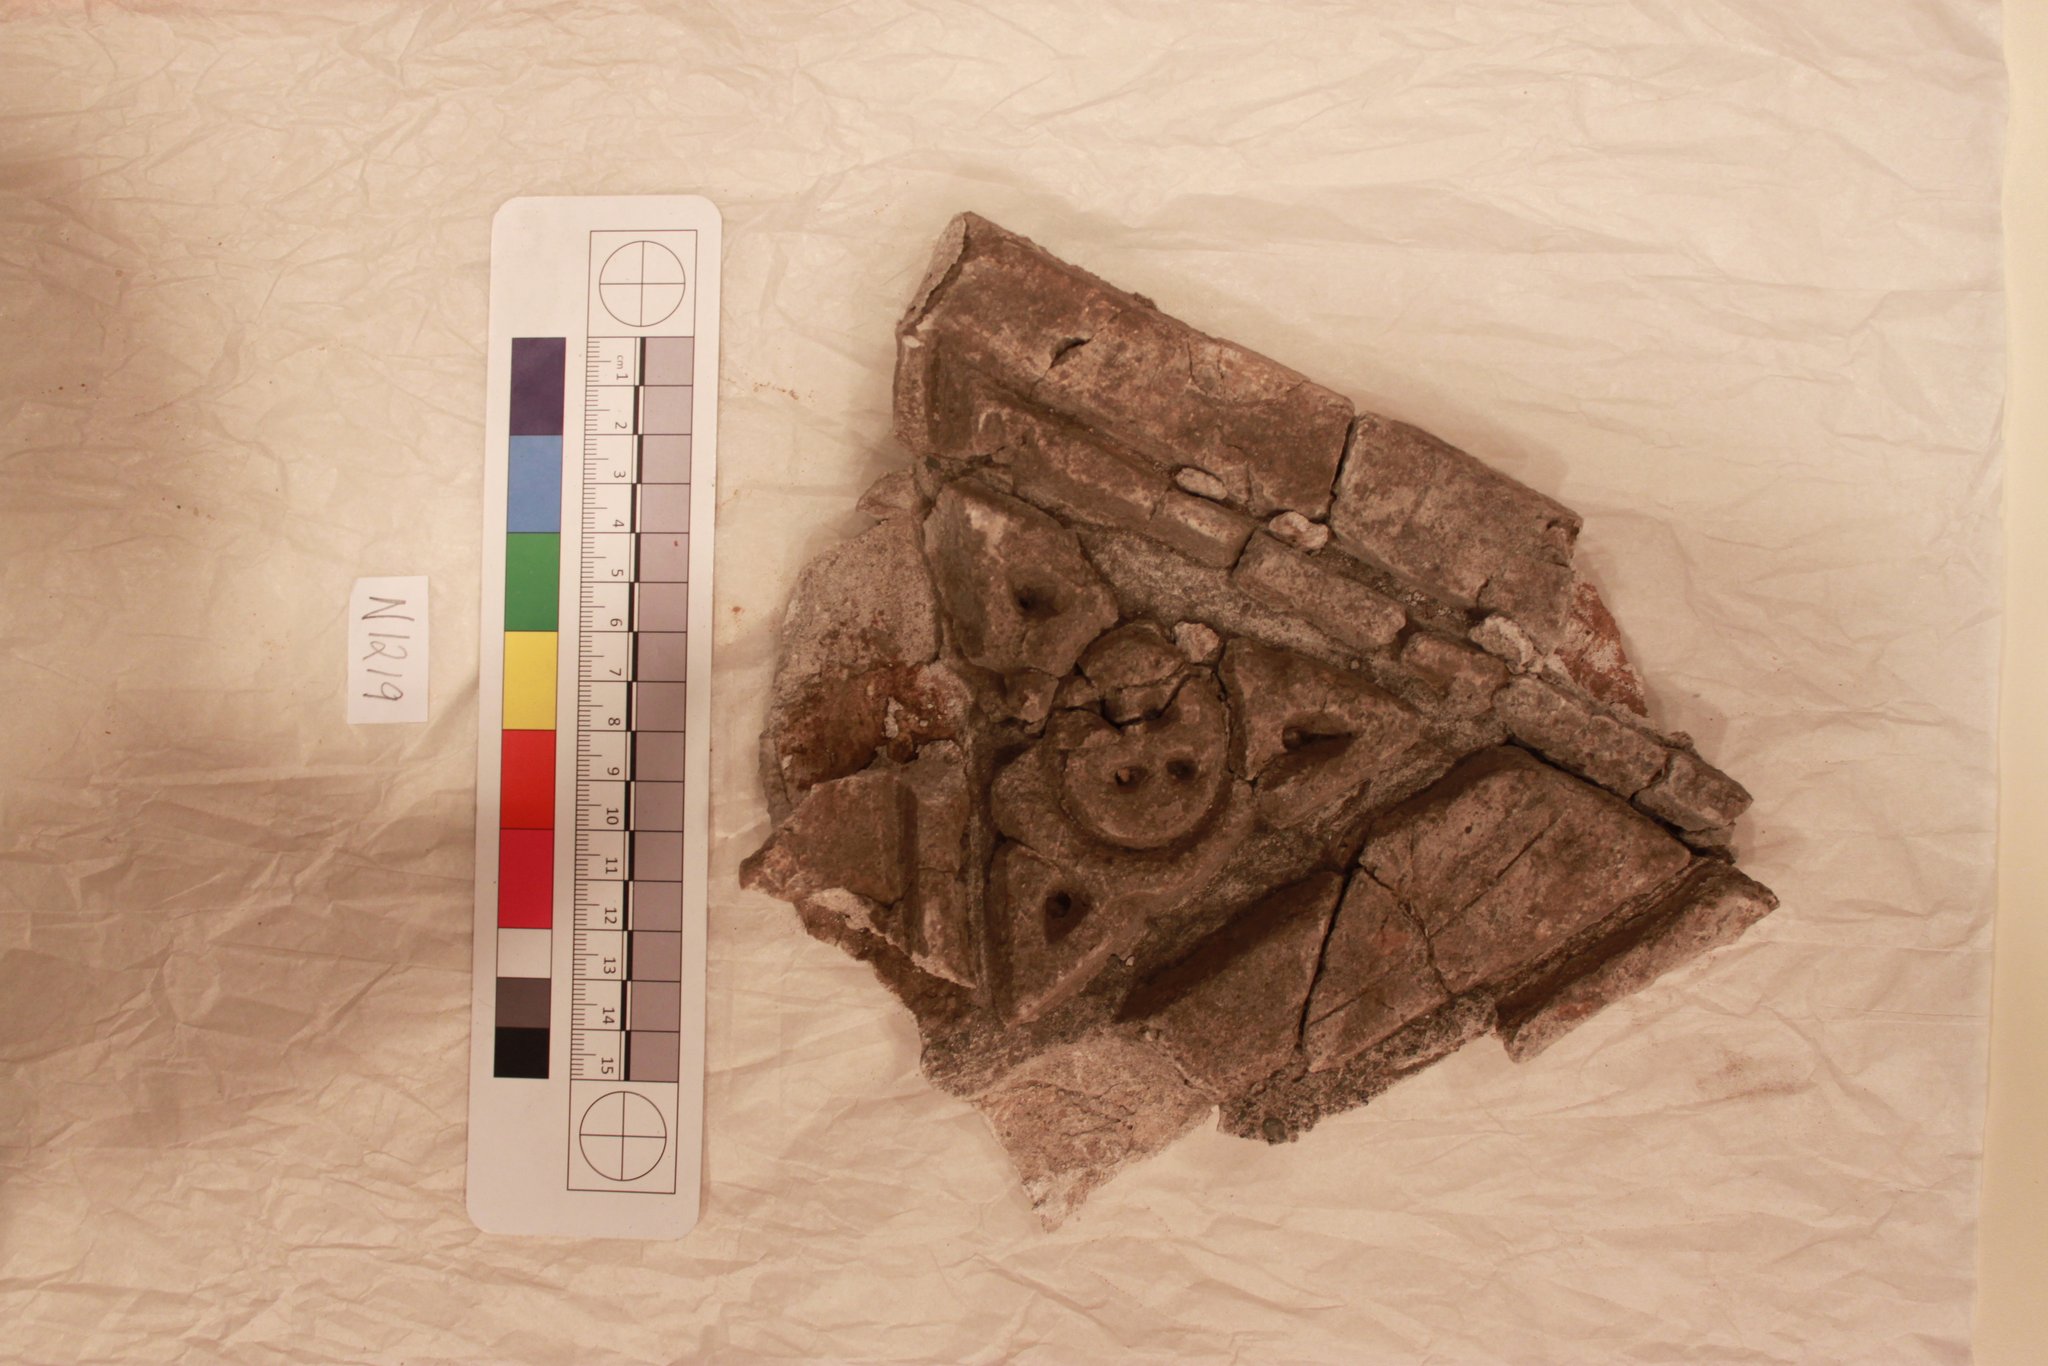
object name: fragment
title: Stucco Fragment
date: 701-1200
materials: plaster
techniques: carving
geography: iran